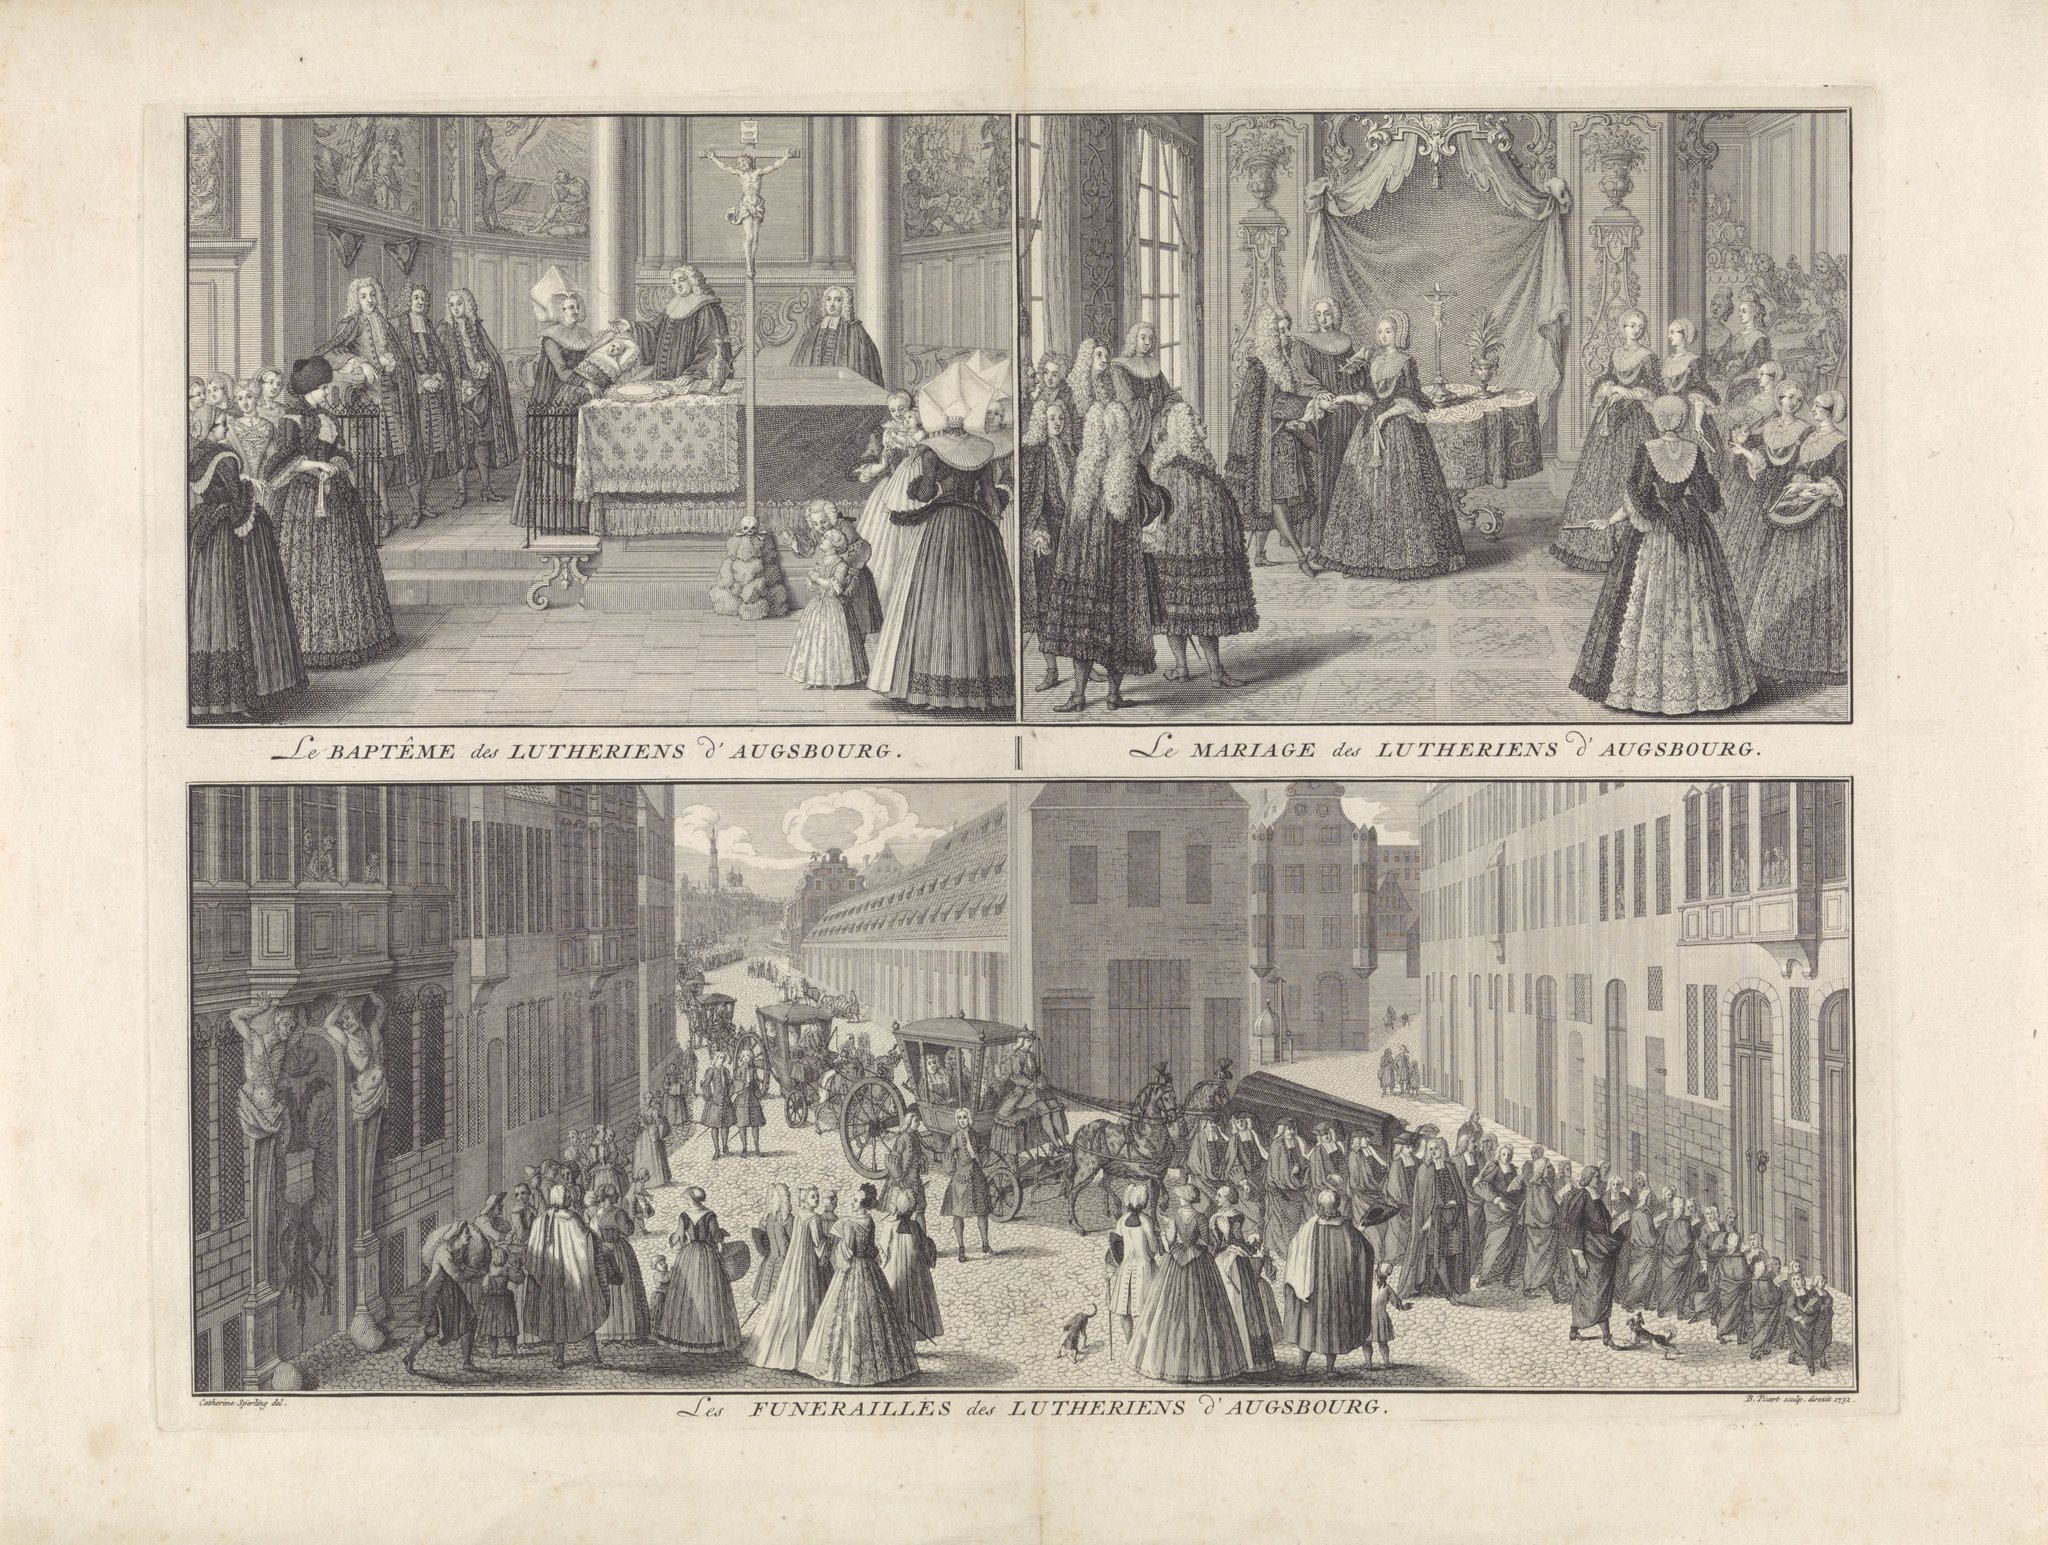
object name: print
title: Doop-, huwelijk- en begrafenisplechtigheid bij de Lutheranen in Augsburg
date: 1732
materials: paper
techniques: engraving, etching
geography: amsterdam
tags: clothes, costume (+ women's clothes), cortege, funeral procession, clothes, costume (+ men's clothes), baptism ~ protestant service, marriage ~ protestant service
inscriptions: signature: ‘Catherine Sperling del.’, collector's mark: Lugt 2228, date: ‘1732’, title: ‘Le Bapteme des Lutheriens d'Augsburg; r.b.: Le Marriage des Lutheriens d'Augsburg; m.o.: Les Funerailles des Lutheriens d'Augsbourg.’, signature and date: ‘B. Picart sculp. direxit 1732’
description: Prent gebruikt in en mogelijk gebruikt in andere edities van: Picart, Bernard. Ceremonies et coutumes religieuses de tous les peuples du monde (...). Tome troisieme, qui contient les cérémonies des Grecs & des protestans. Deel 3. Amsterdam: Jean Frederic Bernard, 1733, na p. 368.